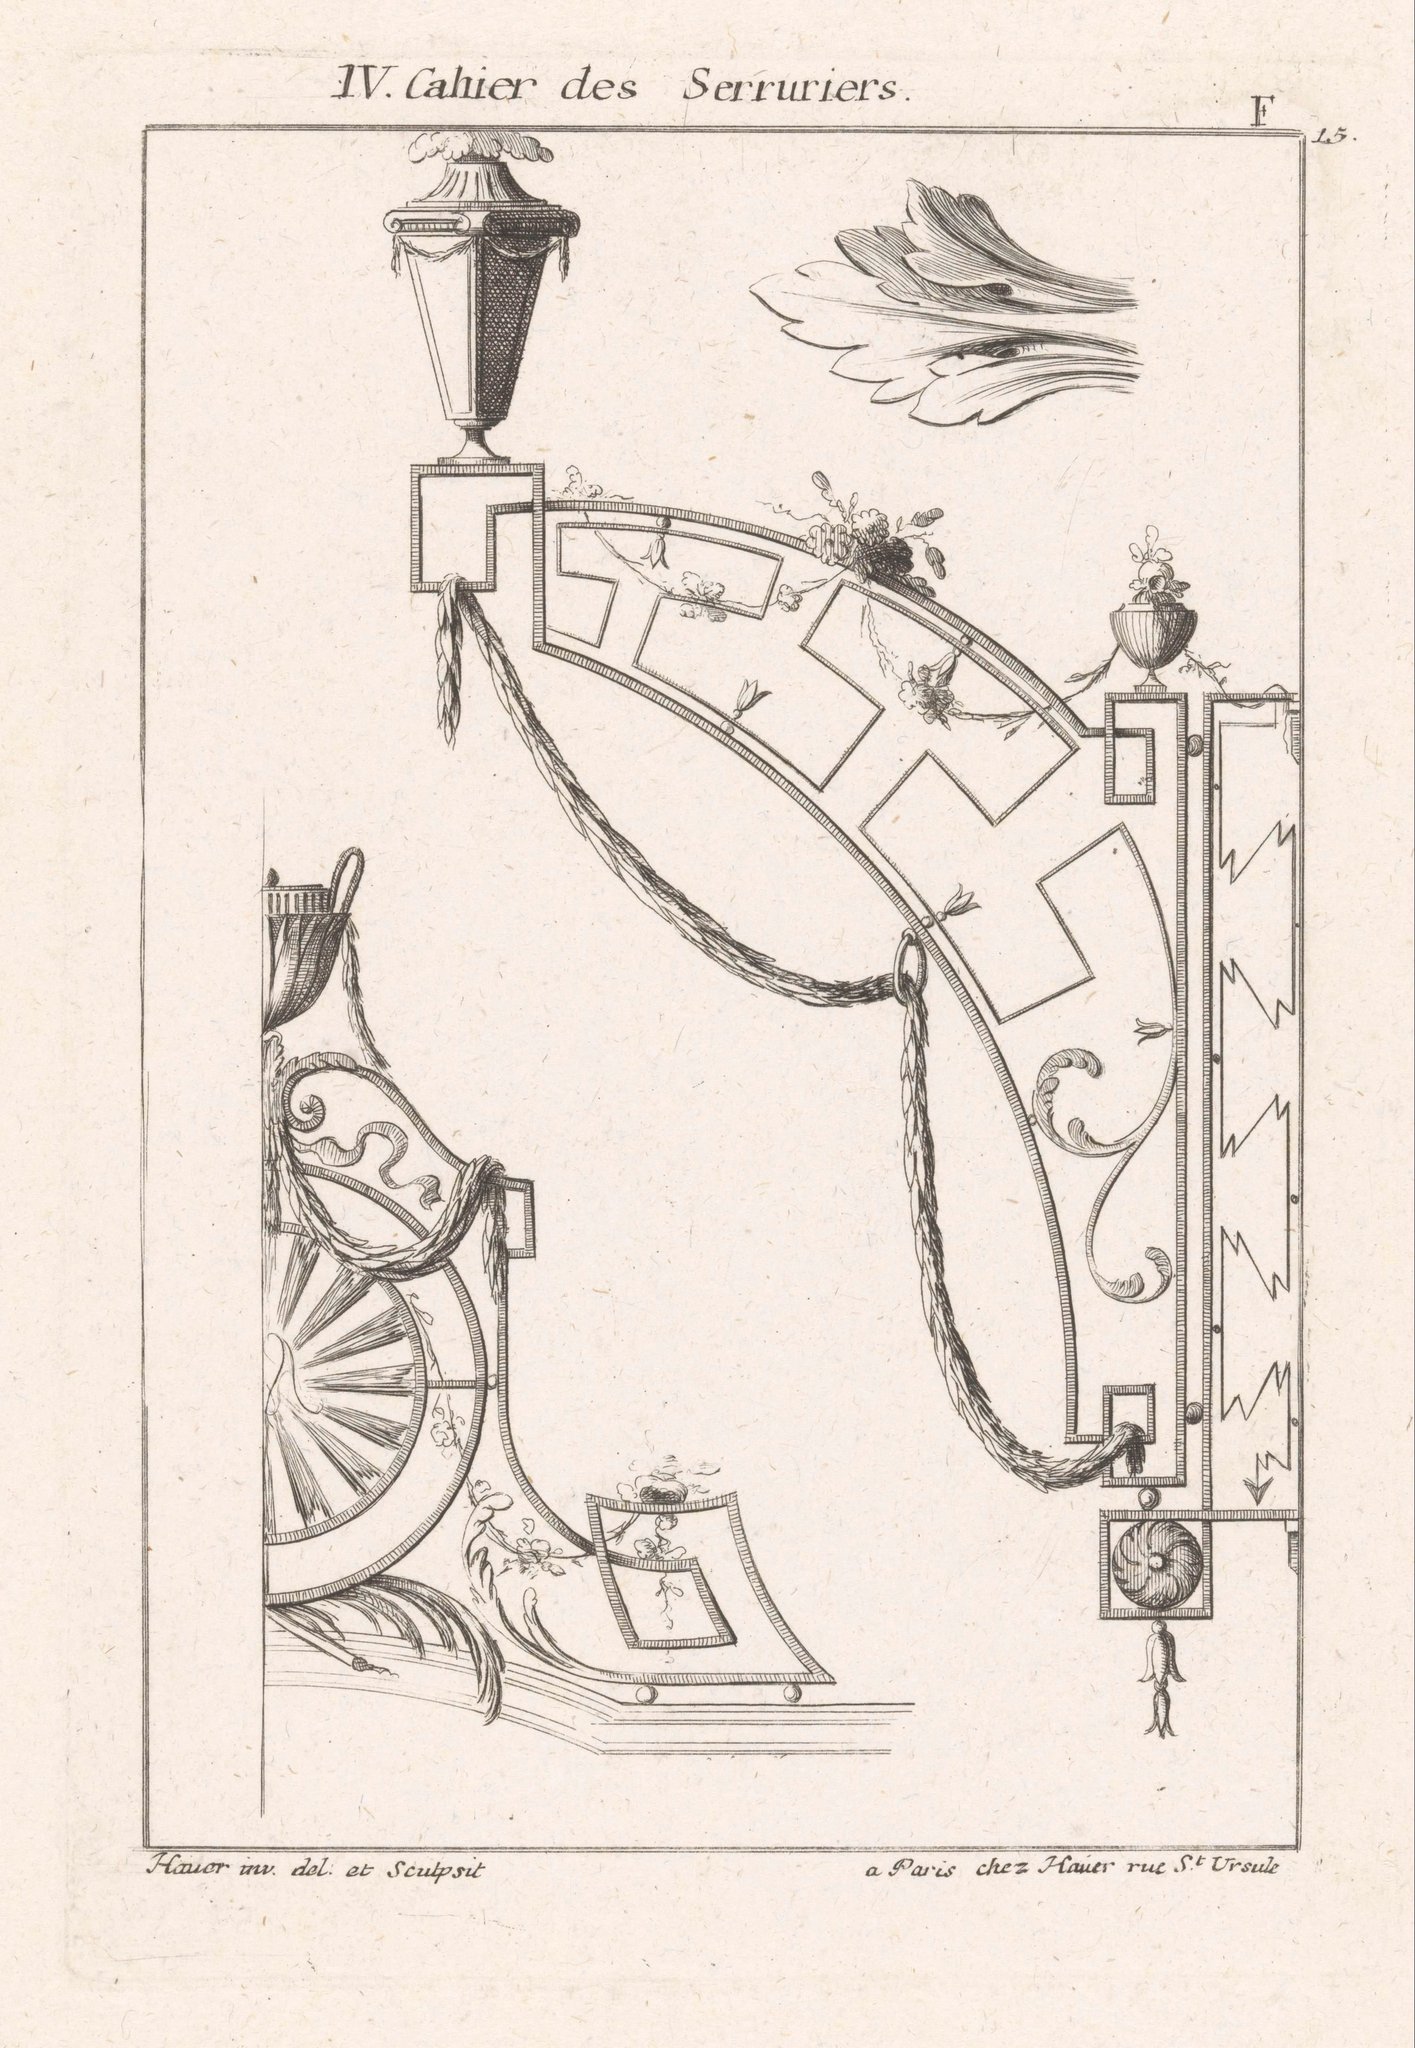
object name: ornament print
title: IV Cahier des Serruriers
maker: johann thomas hauer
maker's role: print maker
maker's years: 1748-1820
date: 1781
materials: paper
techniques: etching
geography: paris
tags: forging (industrial process)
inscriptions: collector's mark: Lugt 2228, collector's mark: Lugt 2760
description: Drie ontwerpen voor smeedwerk met blad- en bloemmotieven, guirlandes en vazen.